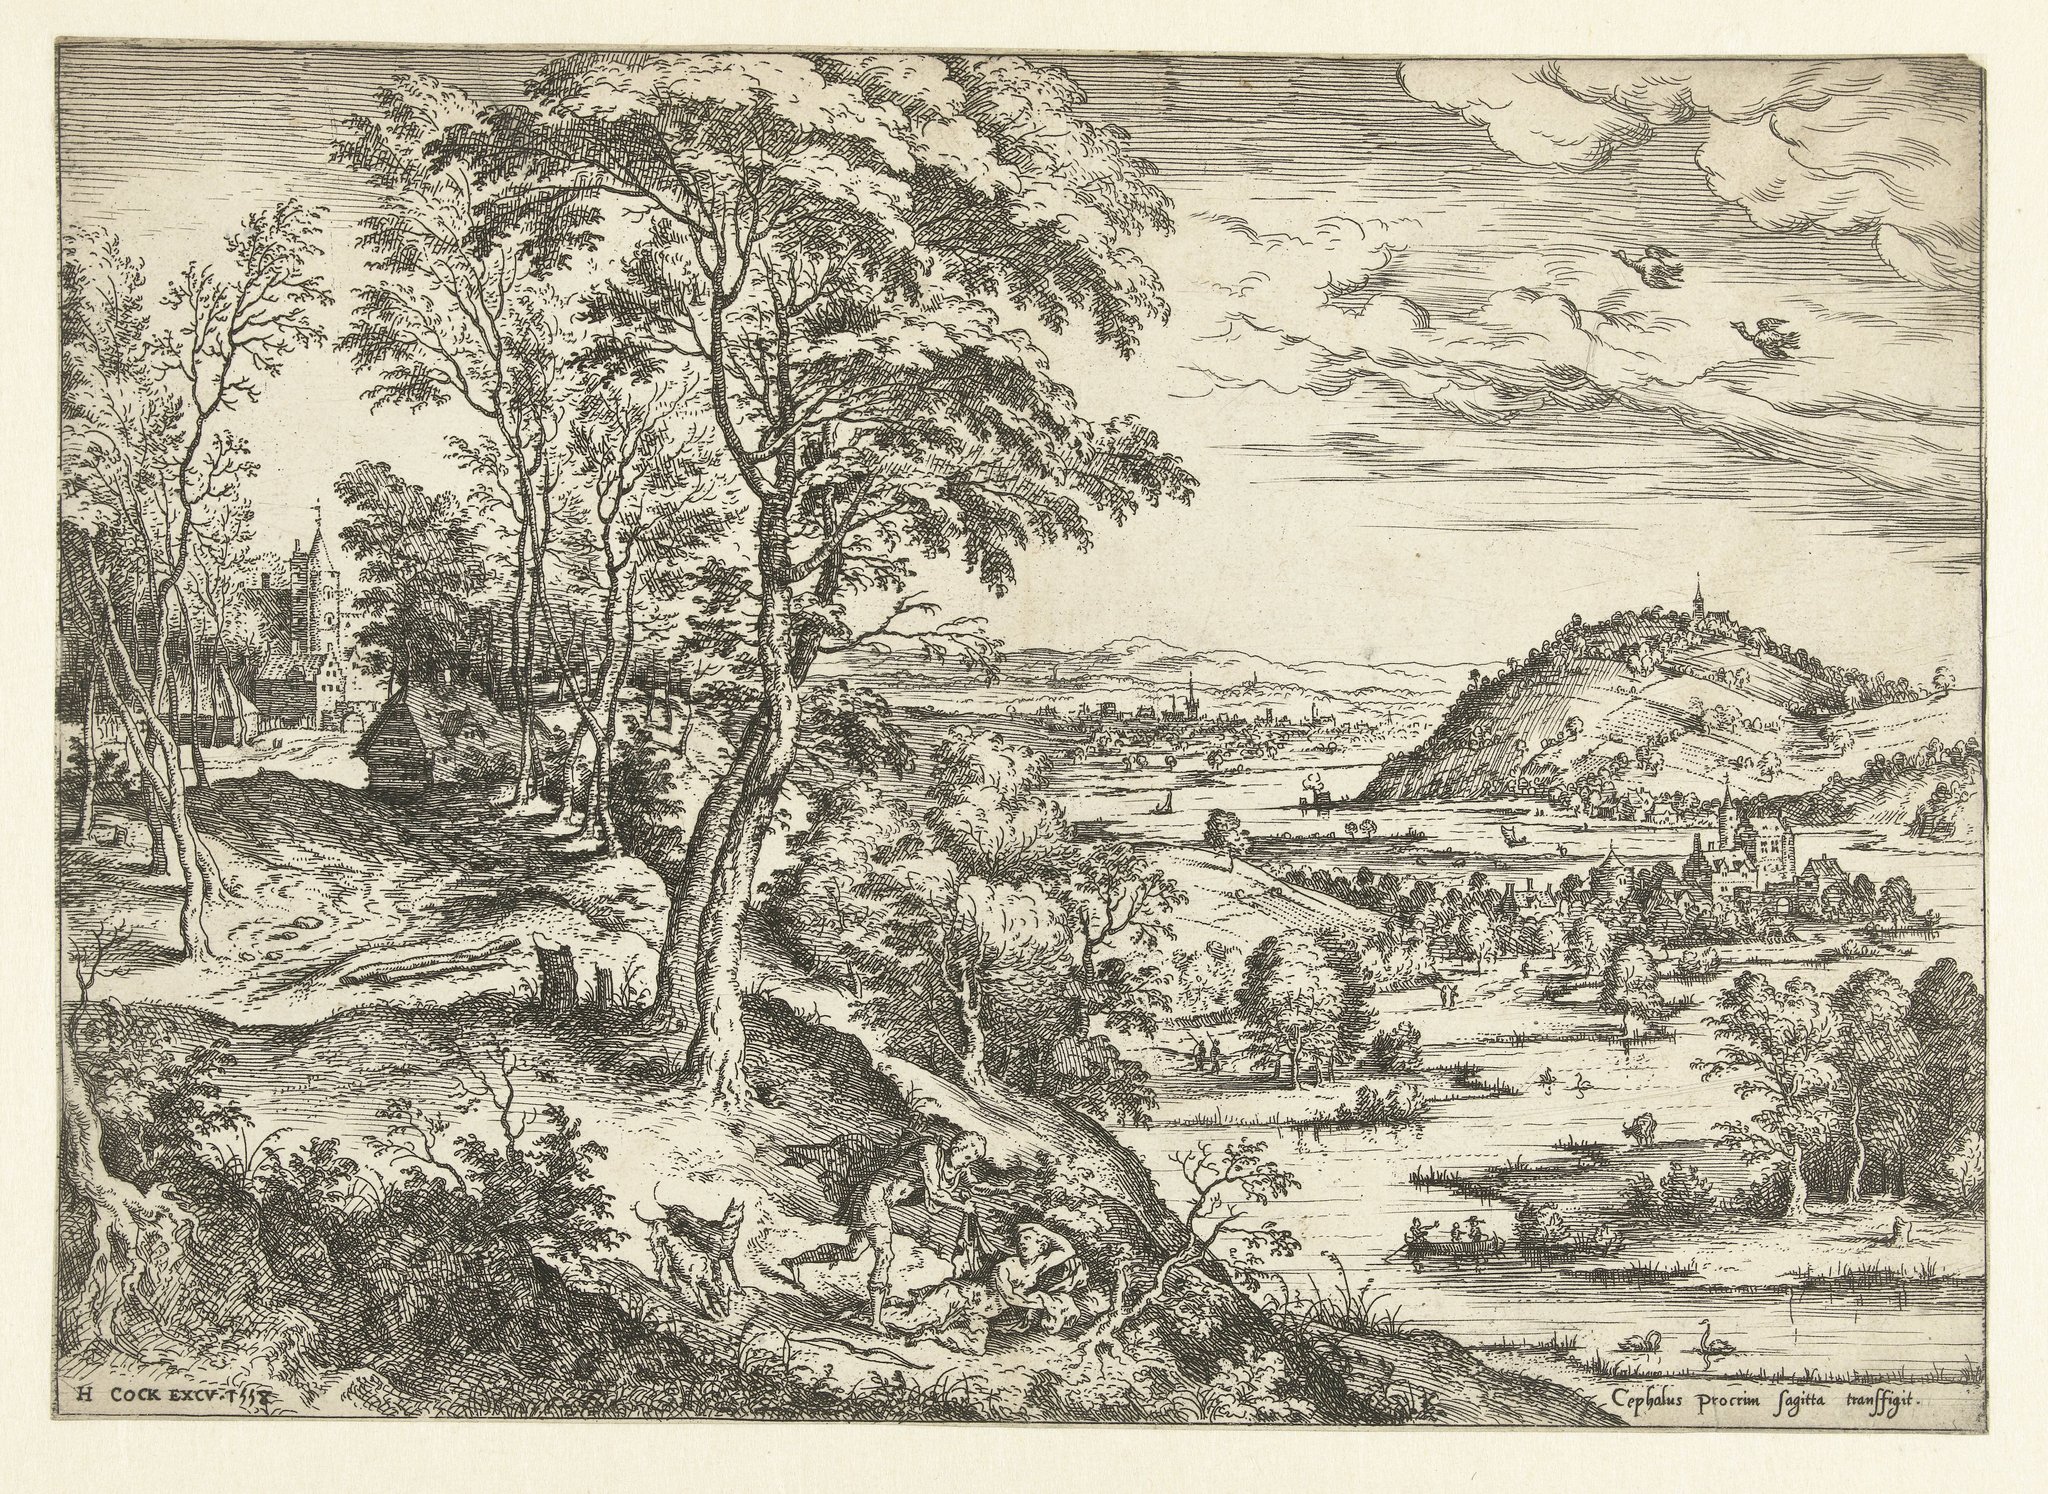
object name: print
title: Cephalus en Procris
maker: hieronymus cock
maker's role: print maker, publisher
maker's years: 1518-1570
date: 1558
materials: paper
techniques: etching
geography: antwerp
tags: cephalus inadvertently kills procris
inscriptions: collector's mark: Lugt 2228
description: Glooiend landschap met een rivierloop. Per ongeluk doodt Cephalus zijn geliefde Procris bij de jacht. Procris rent naar zijn geliefde toe en probeert haar nog te helpen. Prent uit een serie van 13 landschappen met bijbelse en mythologische scènes.